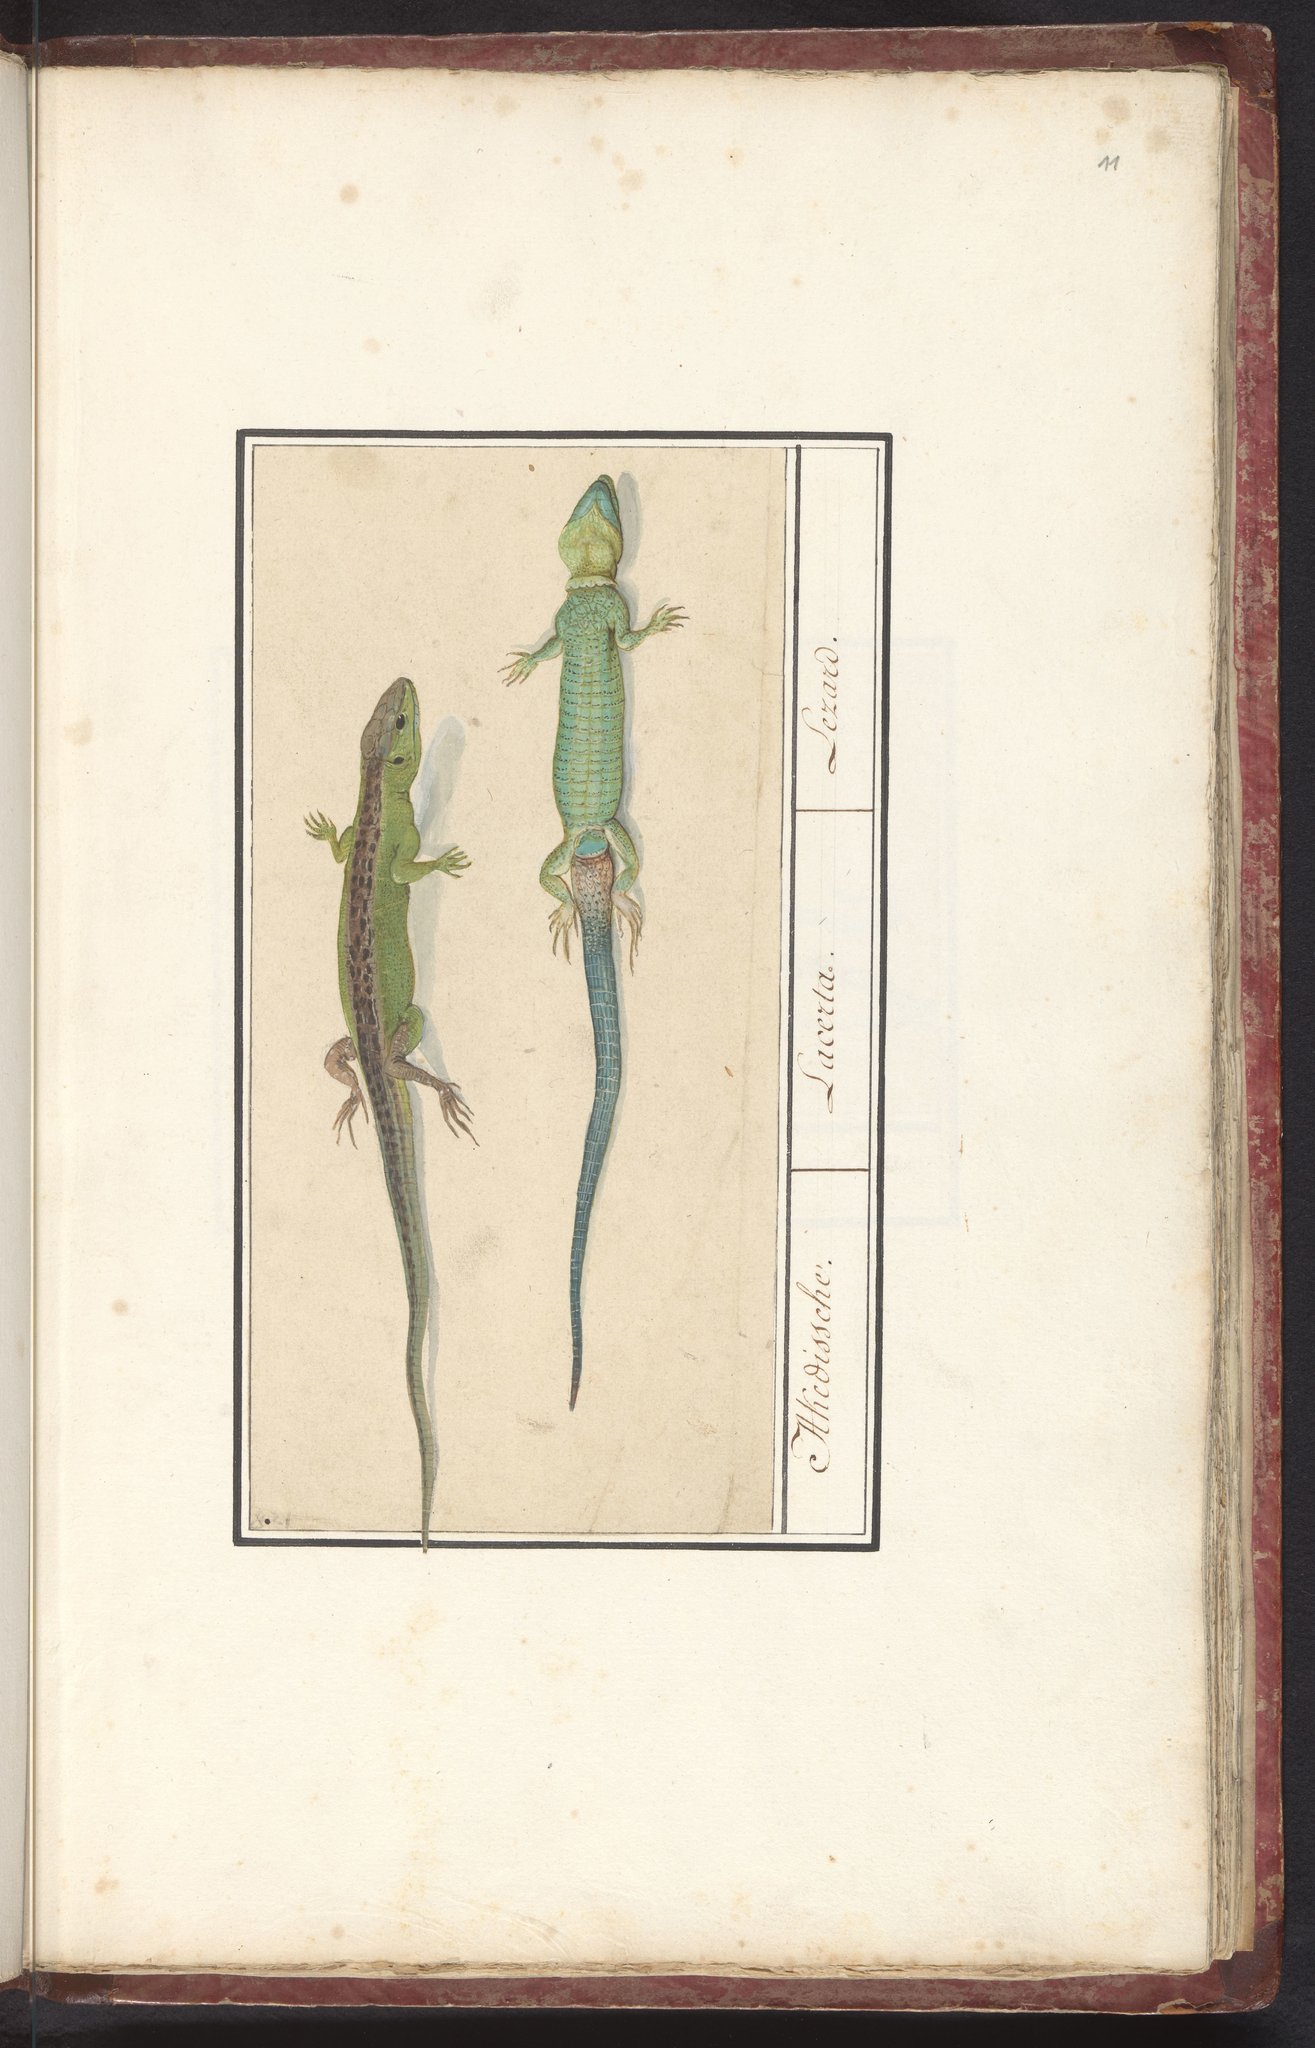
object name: drawing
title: Sand Lizard (Lacerta agilis)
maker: anselmus boëtius de boodt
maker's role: draughtsman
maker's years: 1550-1632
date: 1596-1610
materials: chalk, paint, paper, pencil, watercolor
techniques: brush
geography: prague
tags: lizards: sand lizard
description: Natural science changed dramatically at the end of the 16th century: ancient treatises on the study of nature were rediscovered and supplemented with insights derived from personal observations. This new knowledge was conveyed in illustrated books. De Boodt, too, took a precise and encyclopaedic approach. He included a dorsal as well as a ventral view of this sand lizard.